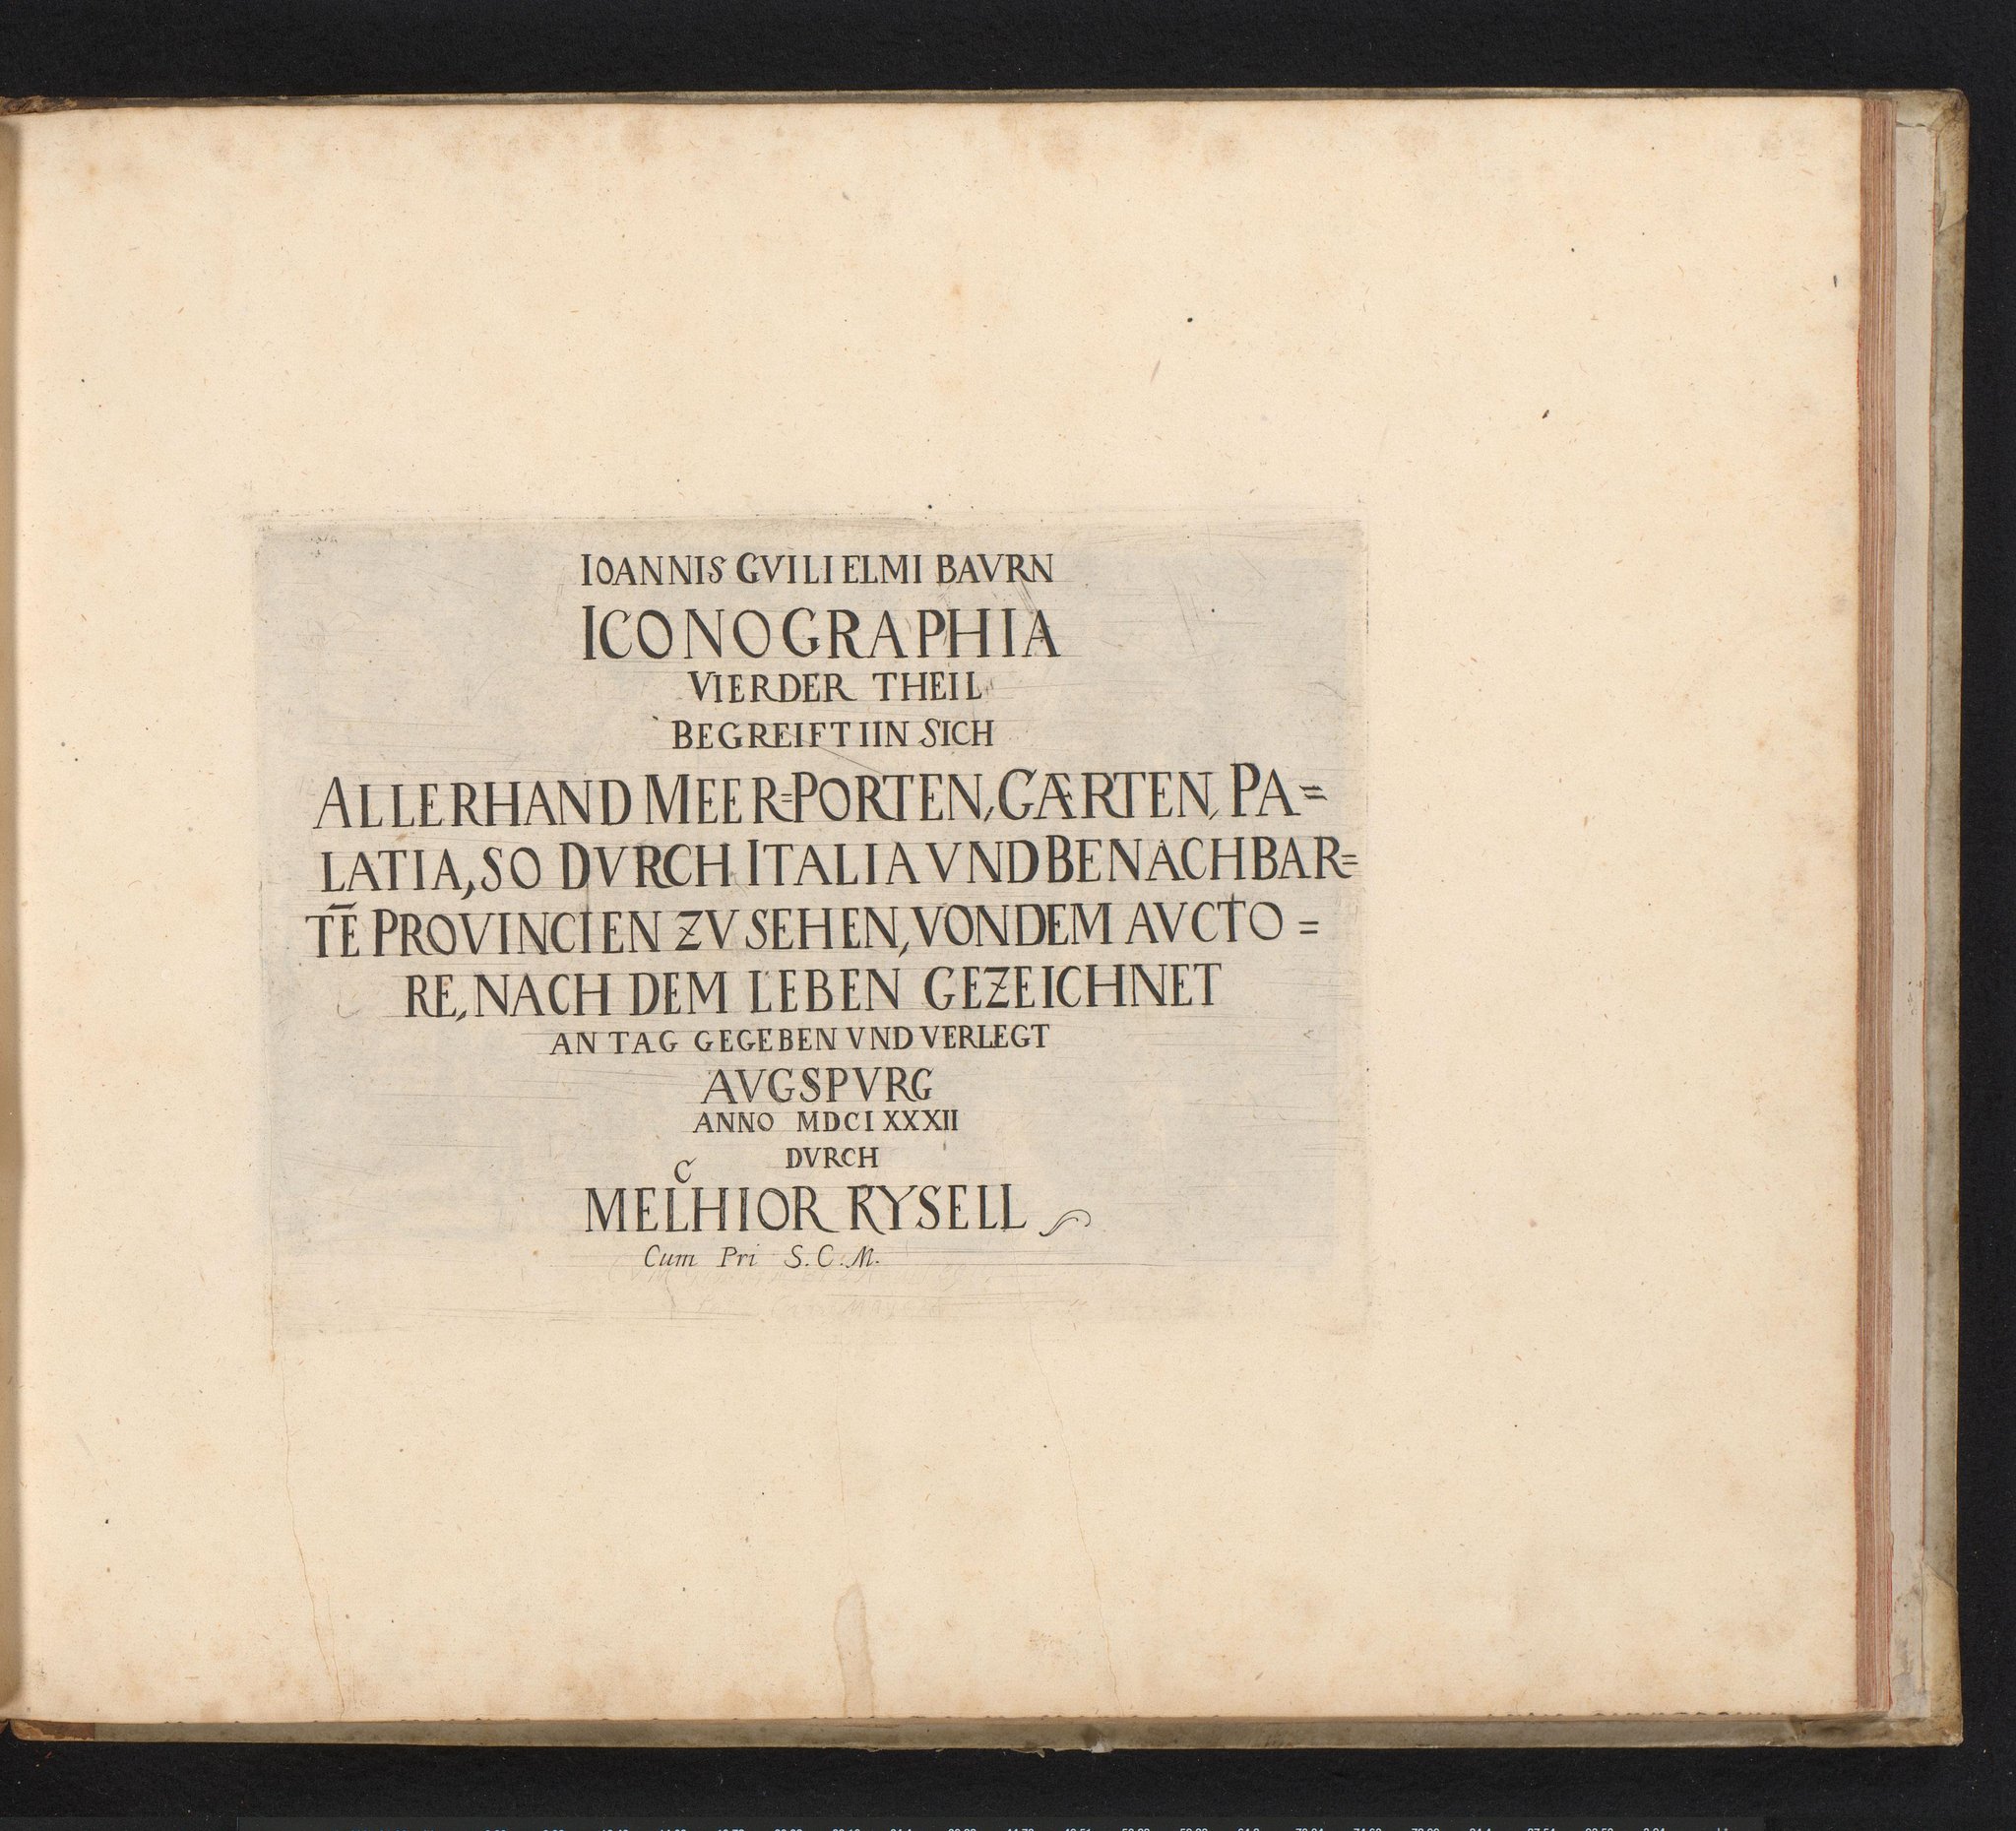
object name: titelprent, frontispice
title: Titelprent voor het vierde deel van de prentserie 'Iconographia'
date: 1682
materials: paper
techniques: etching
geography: augsburg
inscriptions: collector's mark: Lugt 2228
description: Tekst in het Duits. Prent maakt deel uit van een album.